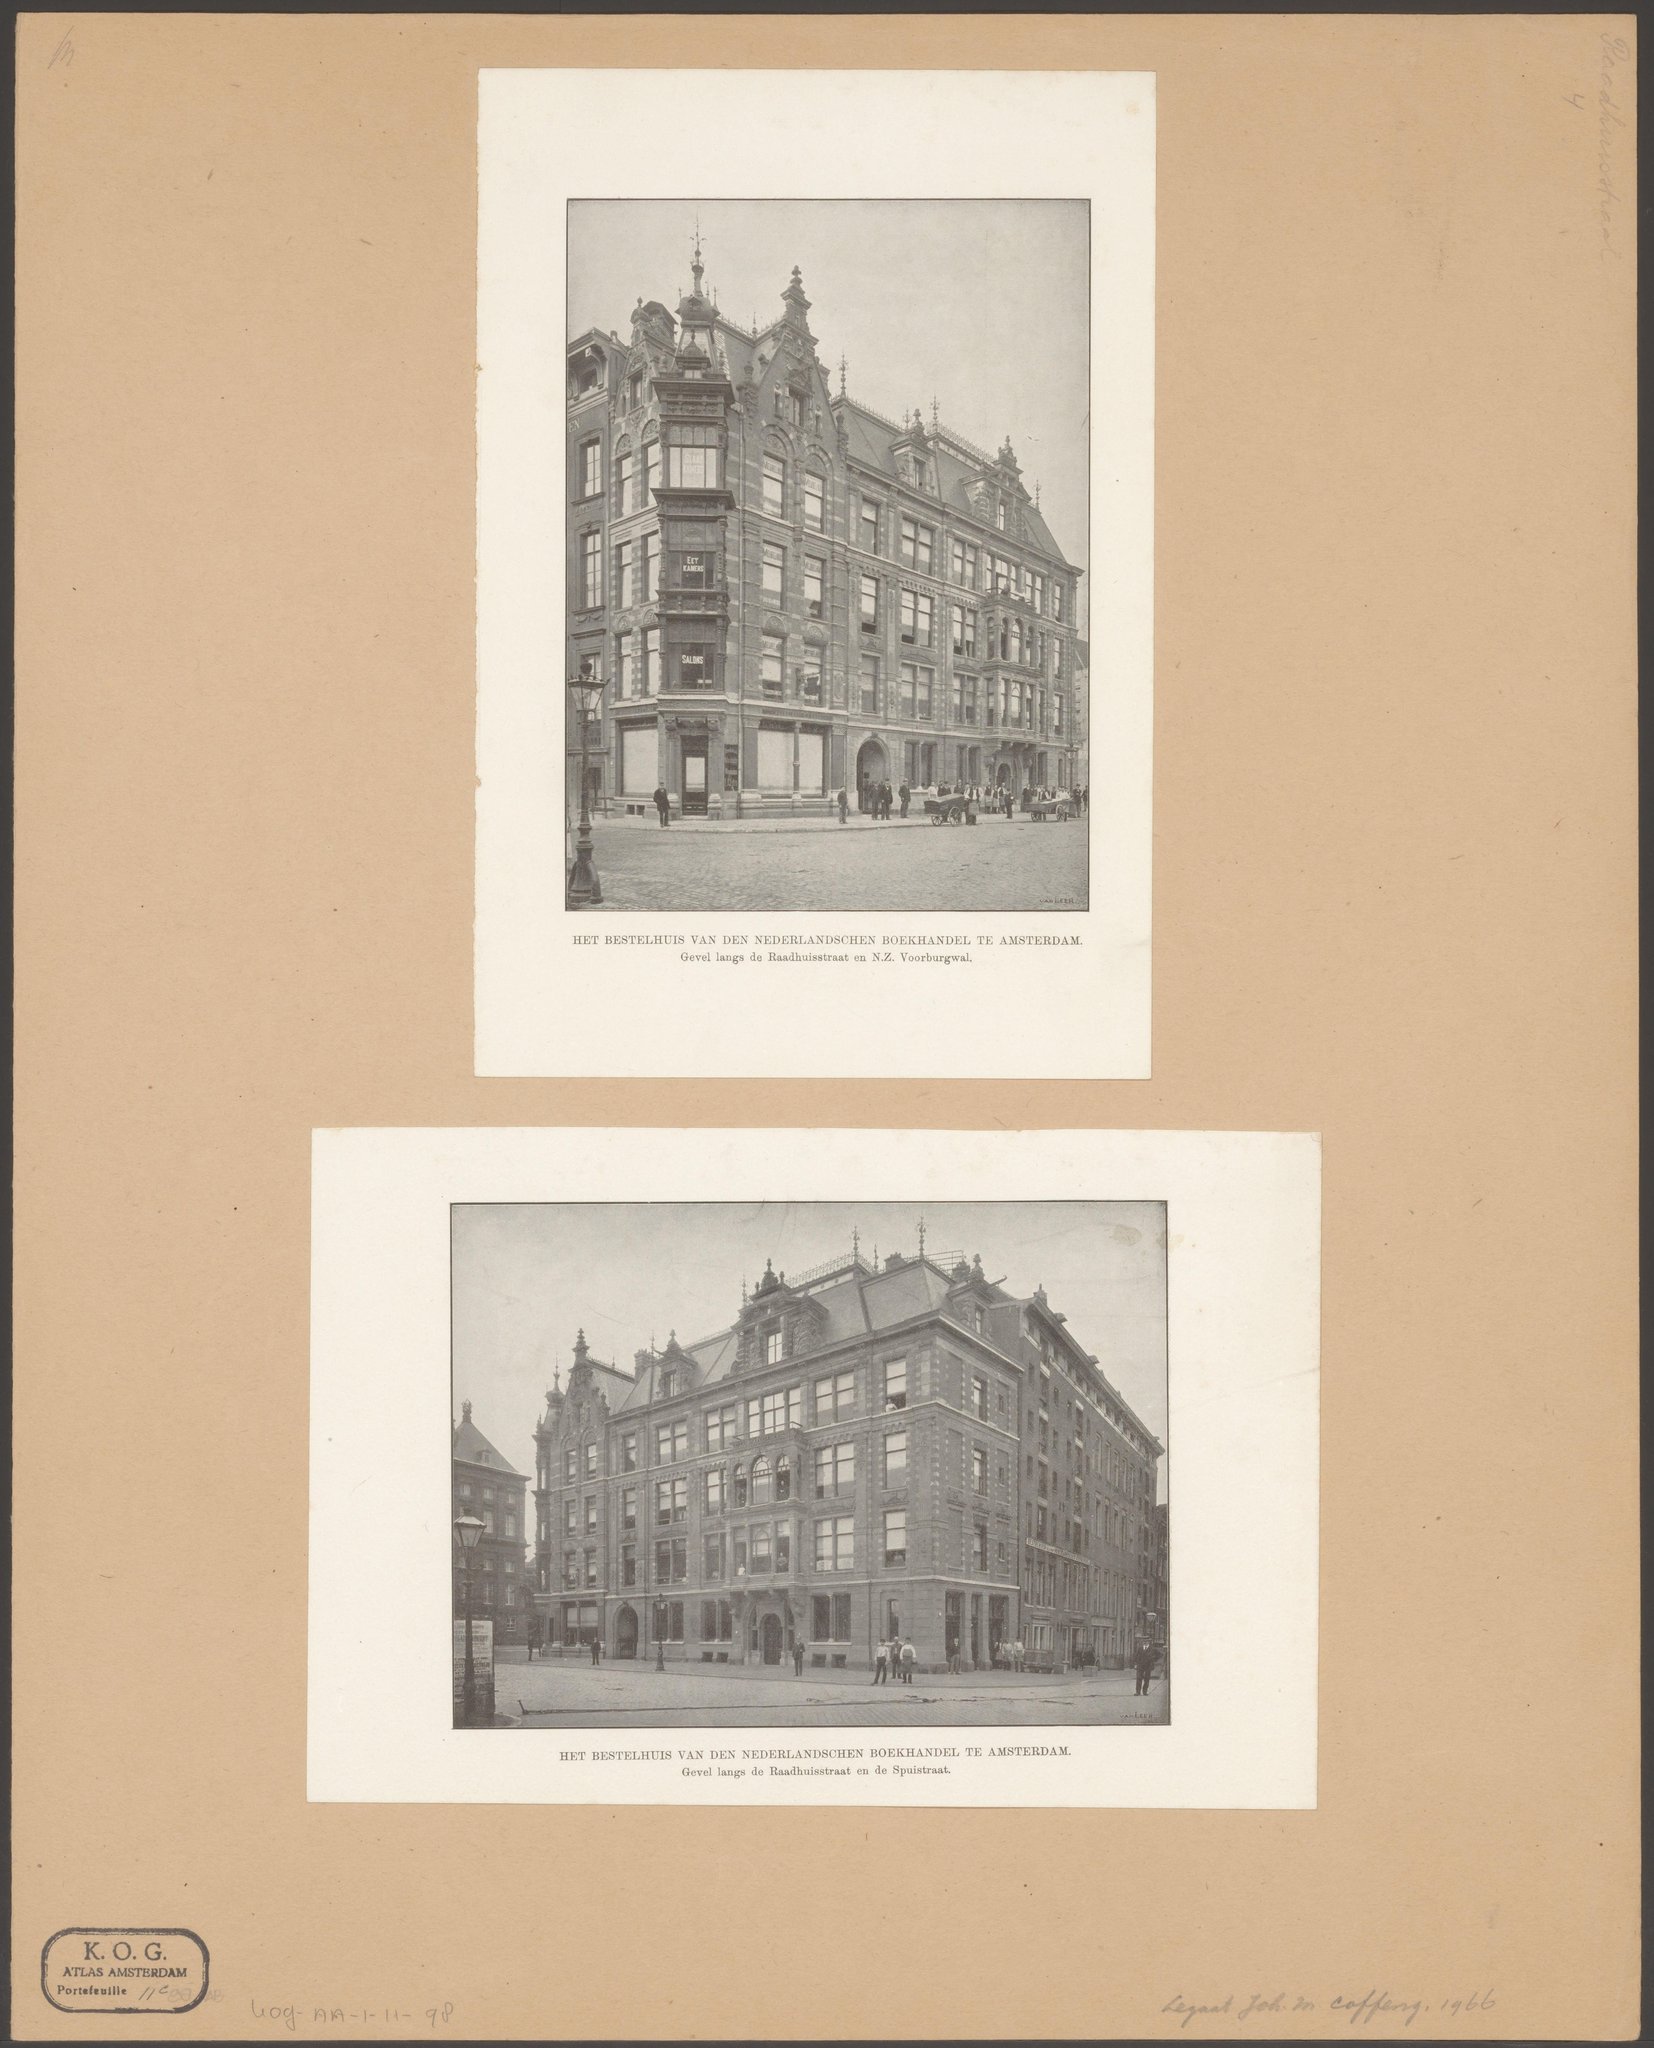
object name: photomechanical print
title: Gezicht op het Bestelhuis van de Nederlandse Boekhandel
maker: Anonymous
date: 1882-1975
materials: paper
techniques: letterpress printing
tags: city-view in general; 'veduta', façade (of house or building), office (~ administration), street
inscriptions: collector's mark: ‘11C98AB’ Lugt 1641b, inscription: ‘Legaat Joh. M. Coffeng. 1966’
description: Onderwerpsrubriek binnen de Atlas Amsterdam: Raadhuisstraat, Raamgracht, Raamplein, Rapenburgerstraat, Reguliersgracht, Reguliersbreestraat.